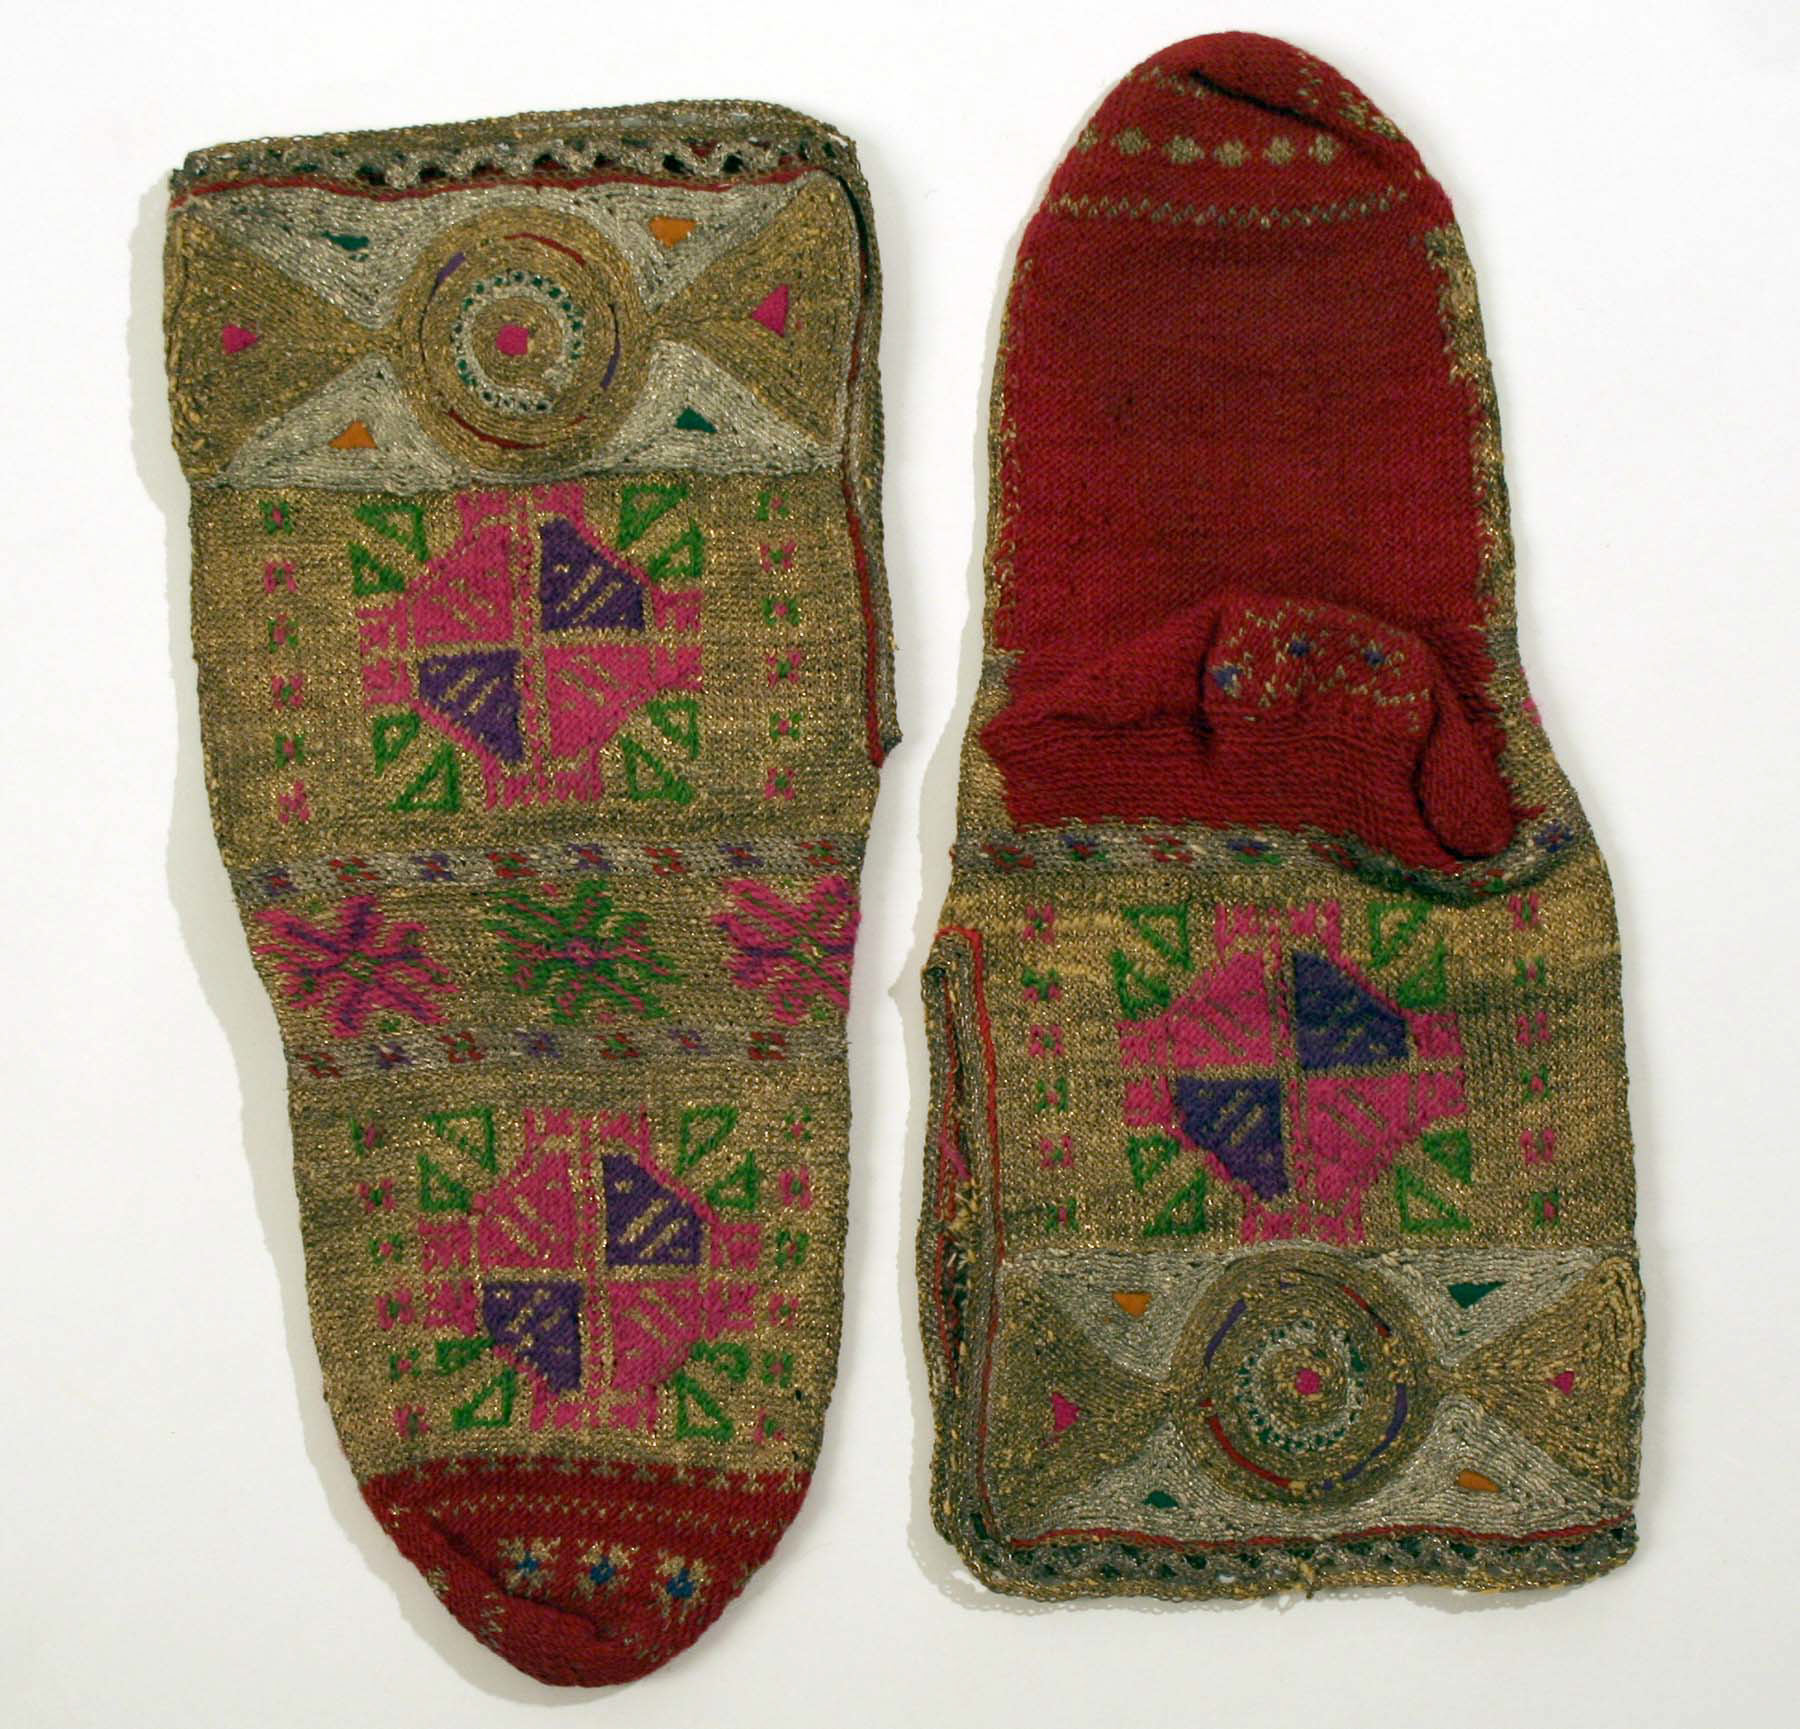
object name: sock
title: Socks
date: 1801-1900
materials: metal thread, wool